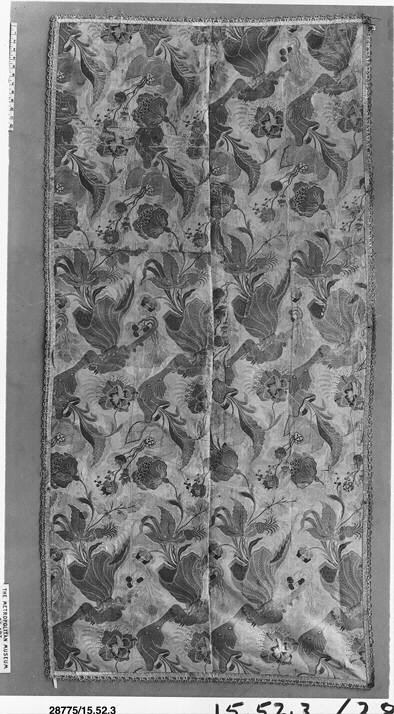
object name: piece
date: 1705-1710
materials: metal thread, silk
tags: flowers,leaves